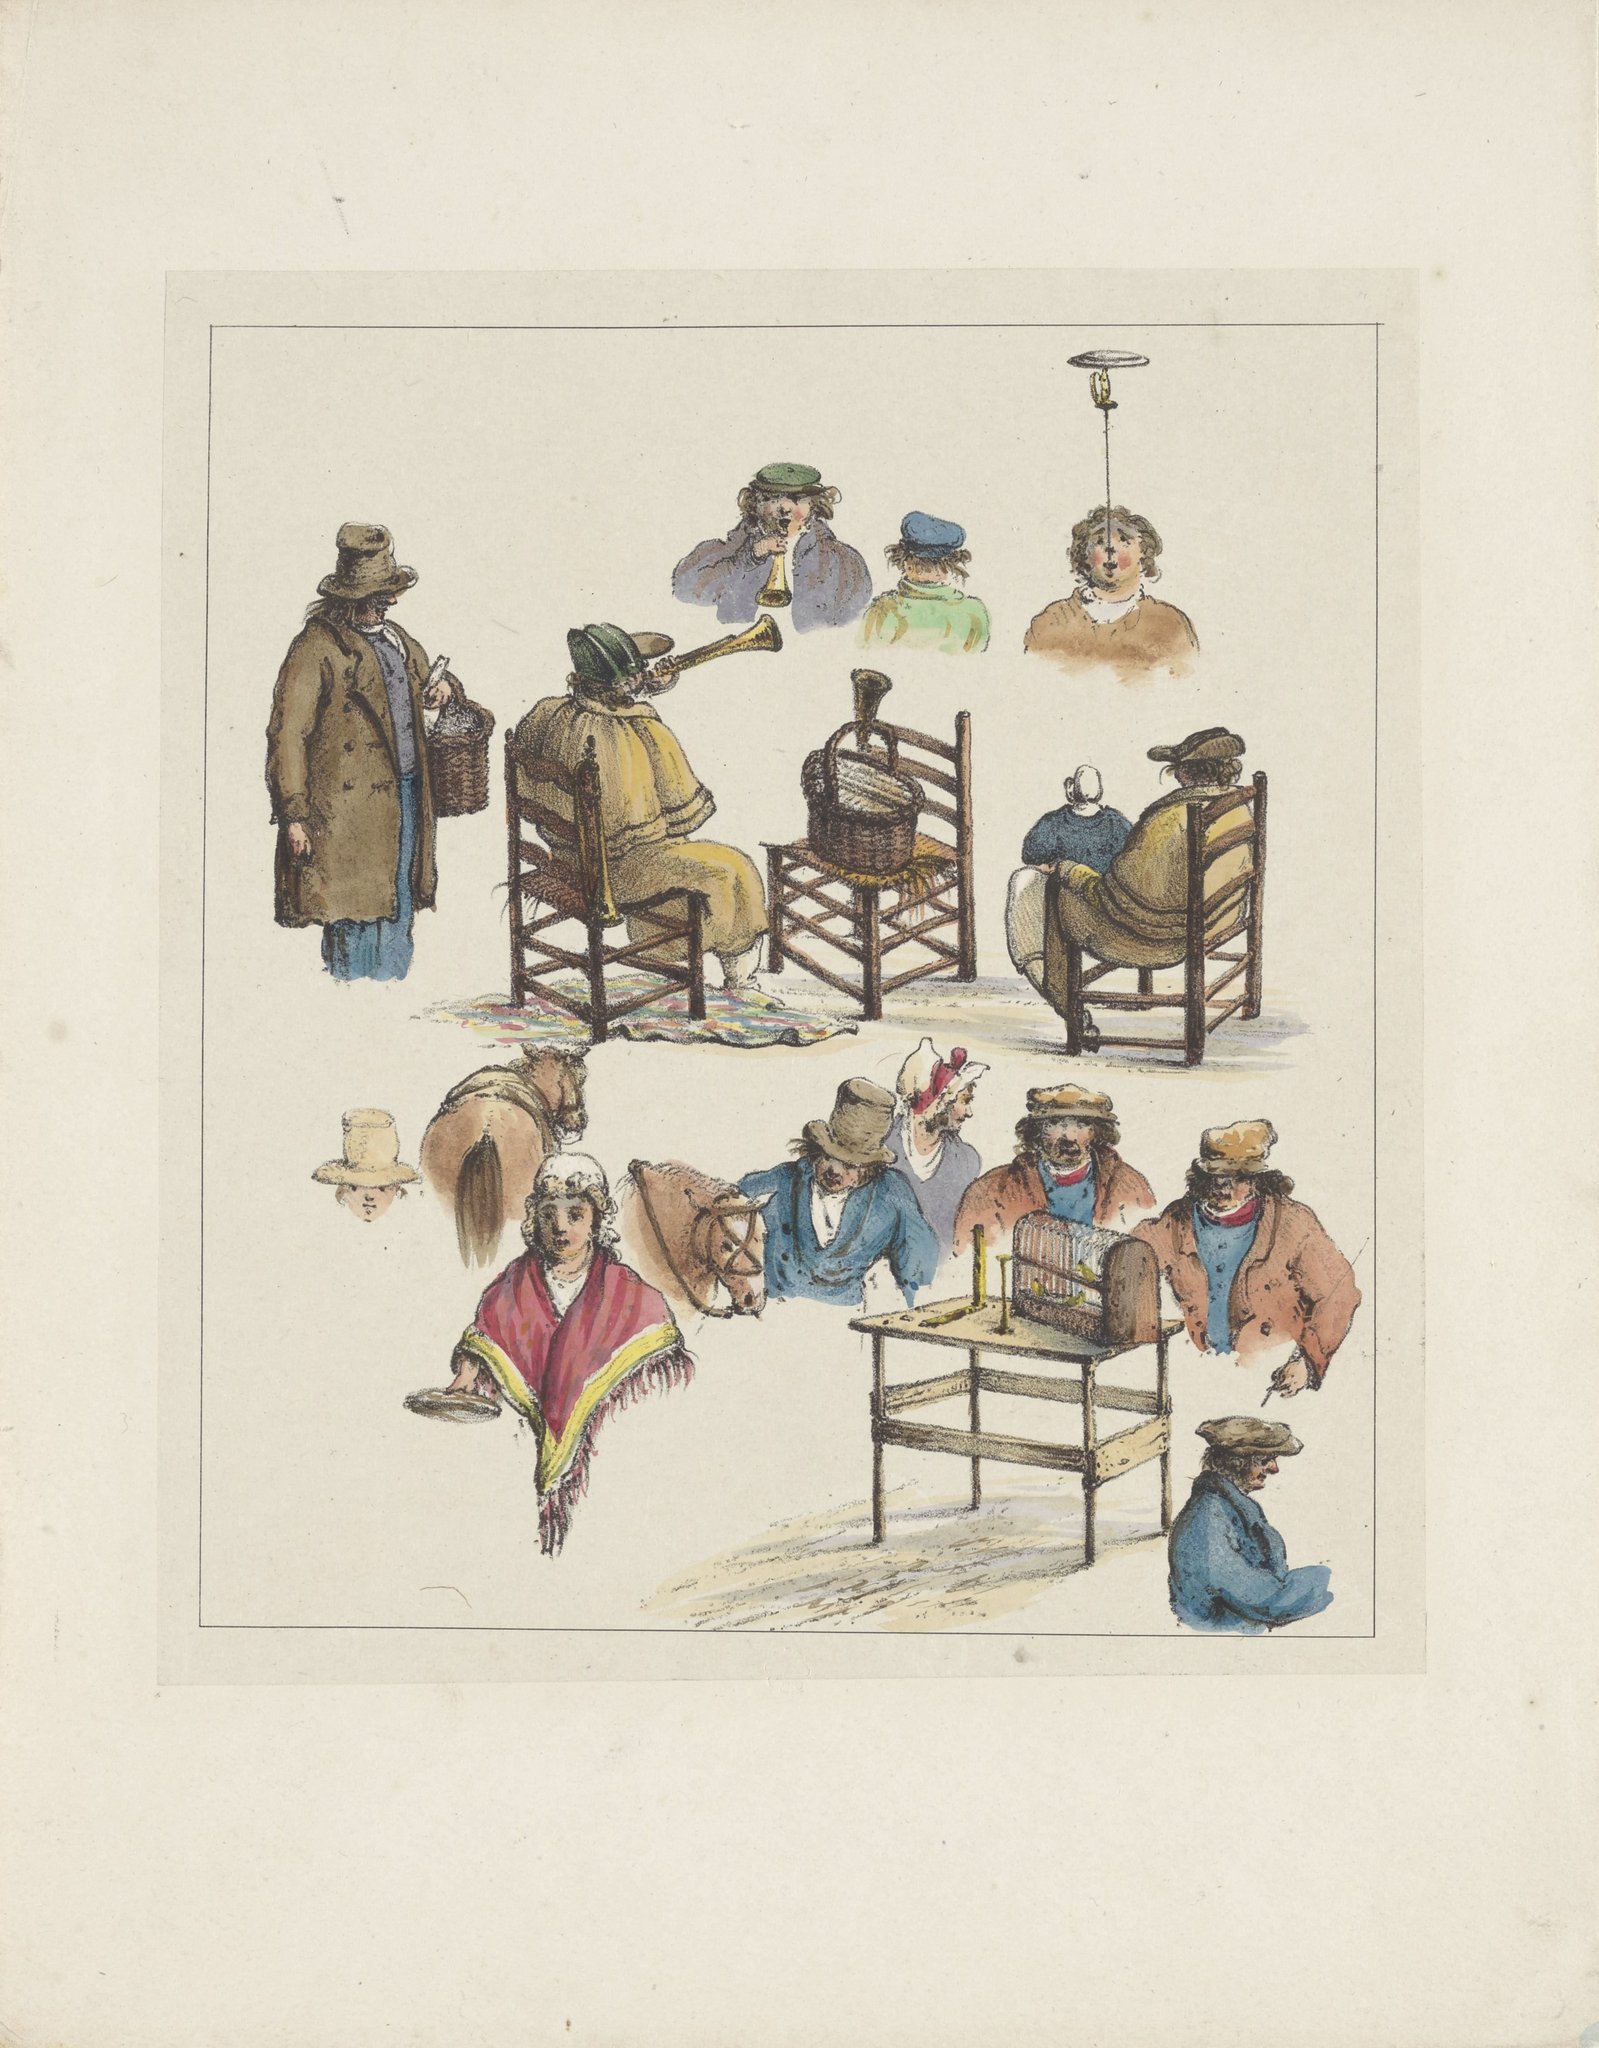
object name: print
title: Fragmenten van Nederlandsche kleederdragt, gebruiken, enz. Naar de natuur geteekend en gelithographieerd door C. Andriessen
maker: christiaan andriessen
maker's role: draughtsman, print maker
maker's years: 1775-1846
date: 1833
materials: paper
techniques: hand coloring, lithograph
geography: netherlands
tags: folk costume, regional costume, bird in a cage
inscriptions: collector's mark: Lugt 2228, collector's mark:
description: Blad met figuren: drie figuren zittend op stoelen, de man links blaast op een trompet. Onderdeel van een serie van zes bladen met figuurstudies van Nederlandse klederdrachten, straatfiguren en gebuiken, 1833.